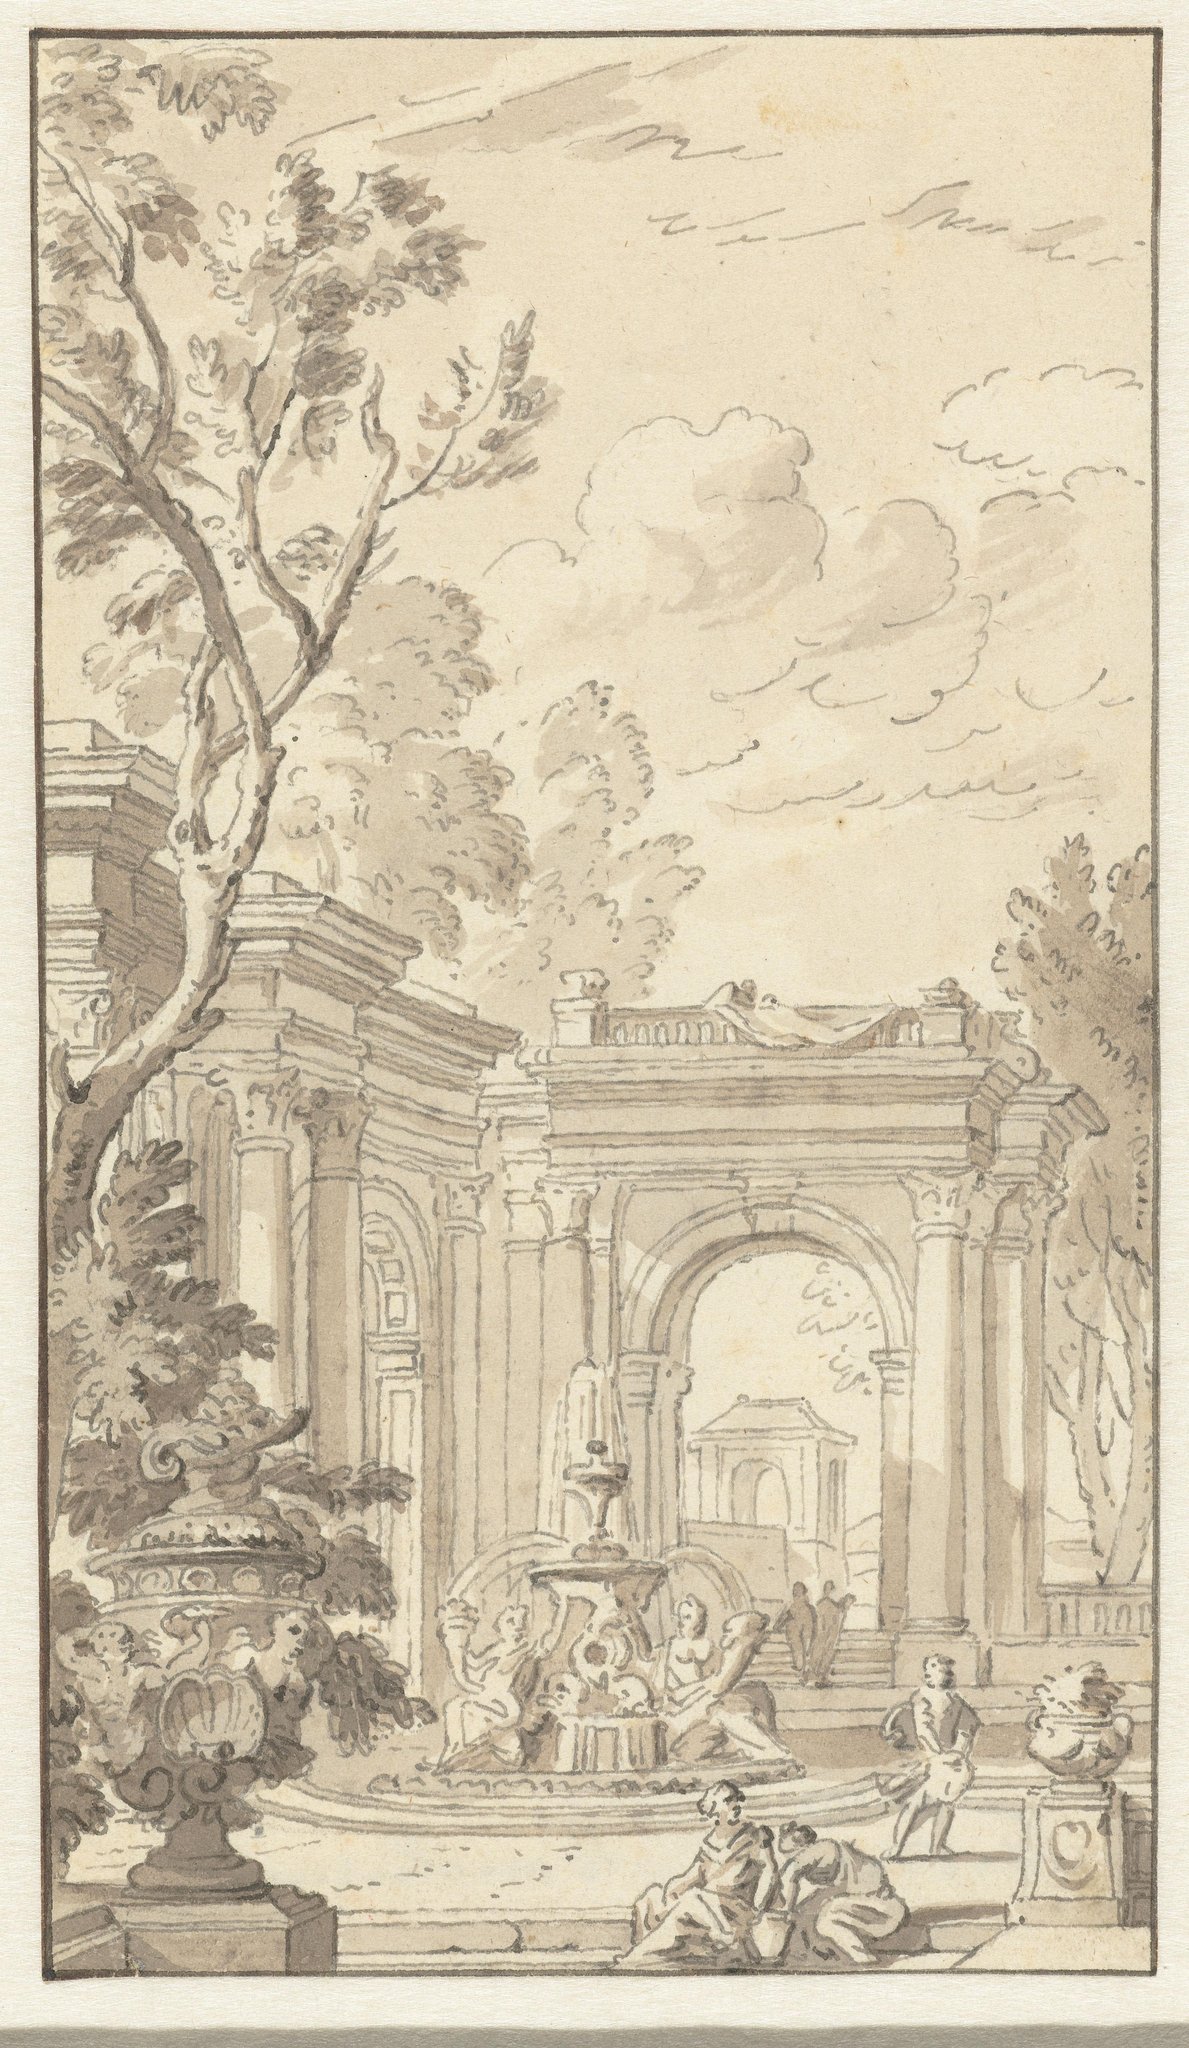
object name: design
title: Ontwerp voor een behangselbeschildering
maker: isaac de moucheron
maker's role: draughtsman, painter, print maker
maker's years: 1667-1744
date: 1677-1744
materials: ink, paper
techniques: brush, pen